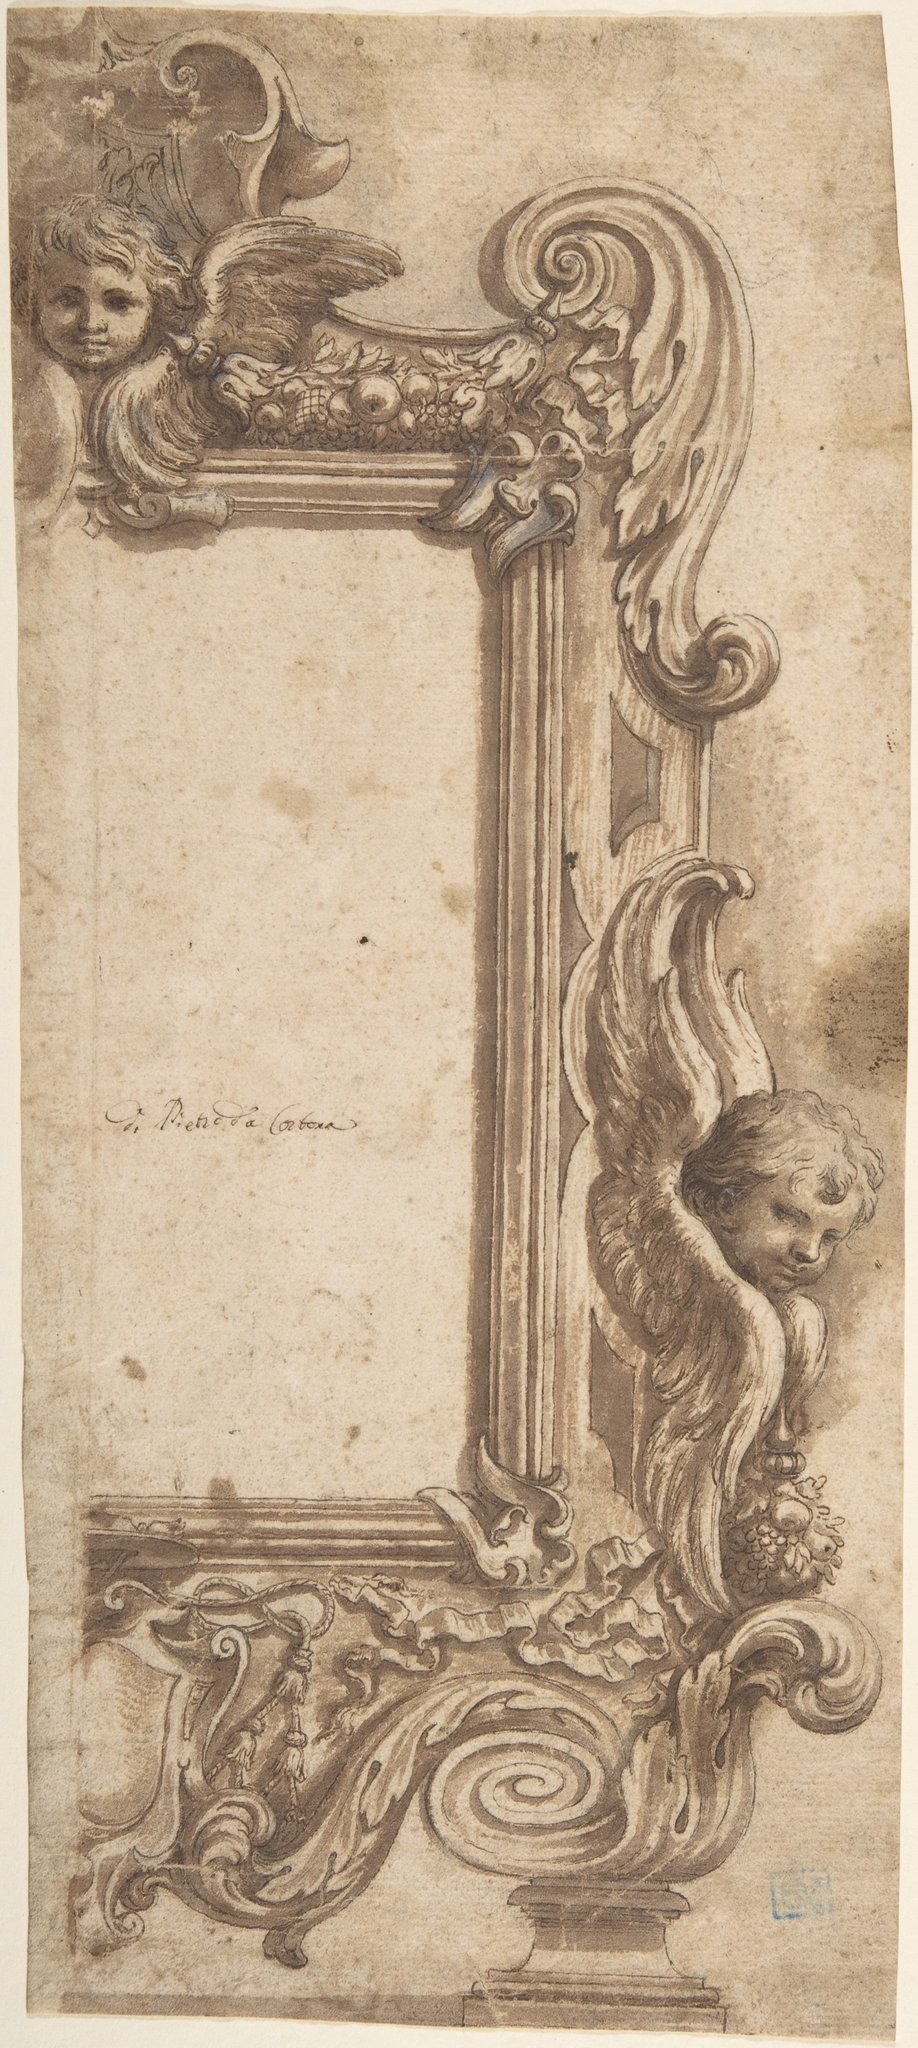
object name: drawing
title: Design for a Half Frame Decorated with Angels, Volutes and Garlands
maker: ciro ferri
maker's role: artist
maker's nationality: italian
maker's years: 1634-1689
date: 1634-1689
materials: gouache, graphite, ink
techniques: brush, highlighting, pen, wash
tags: garlands,angels